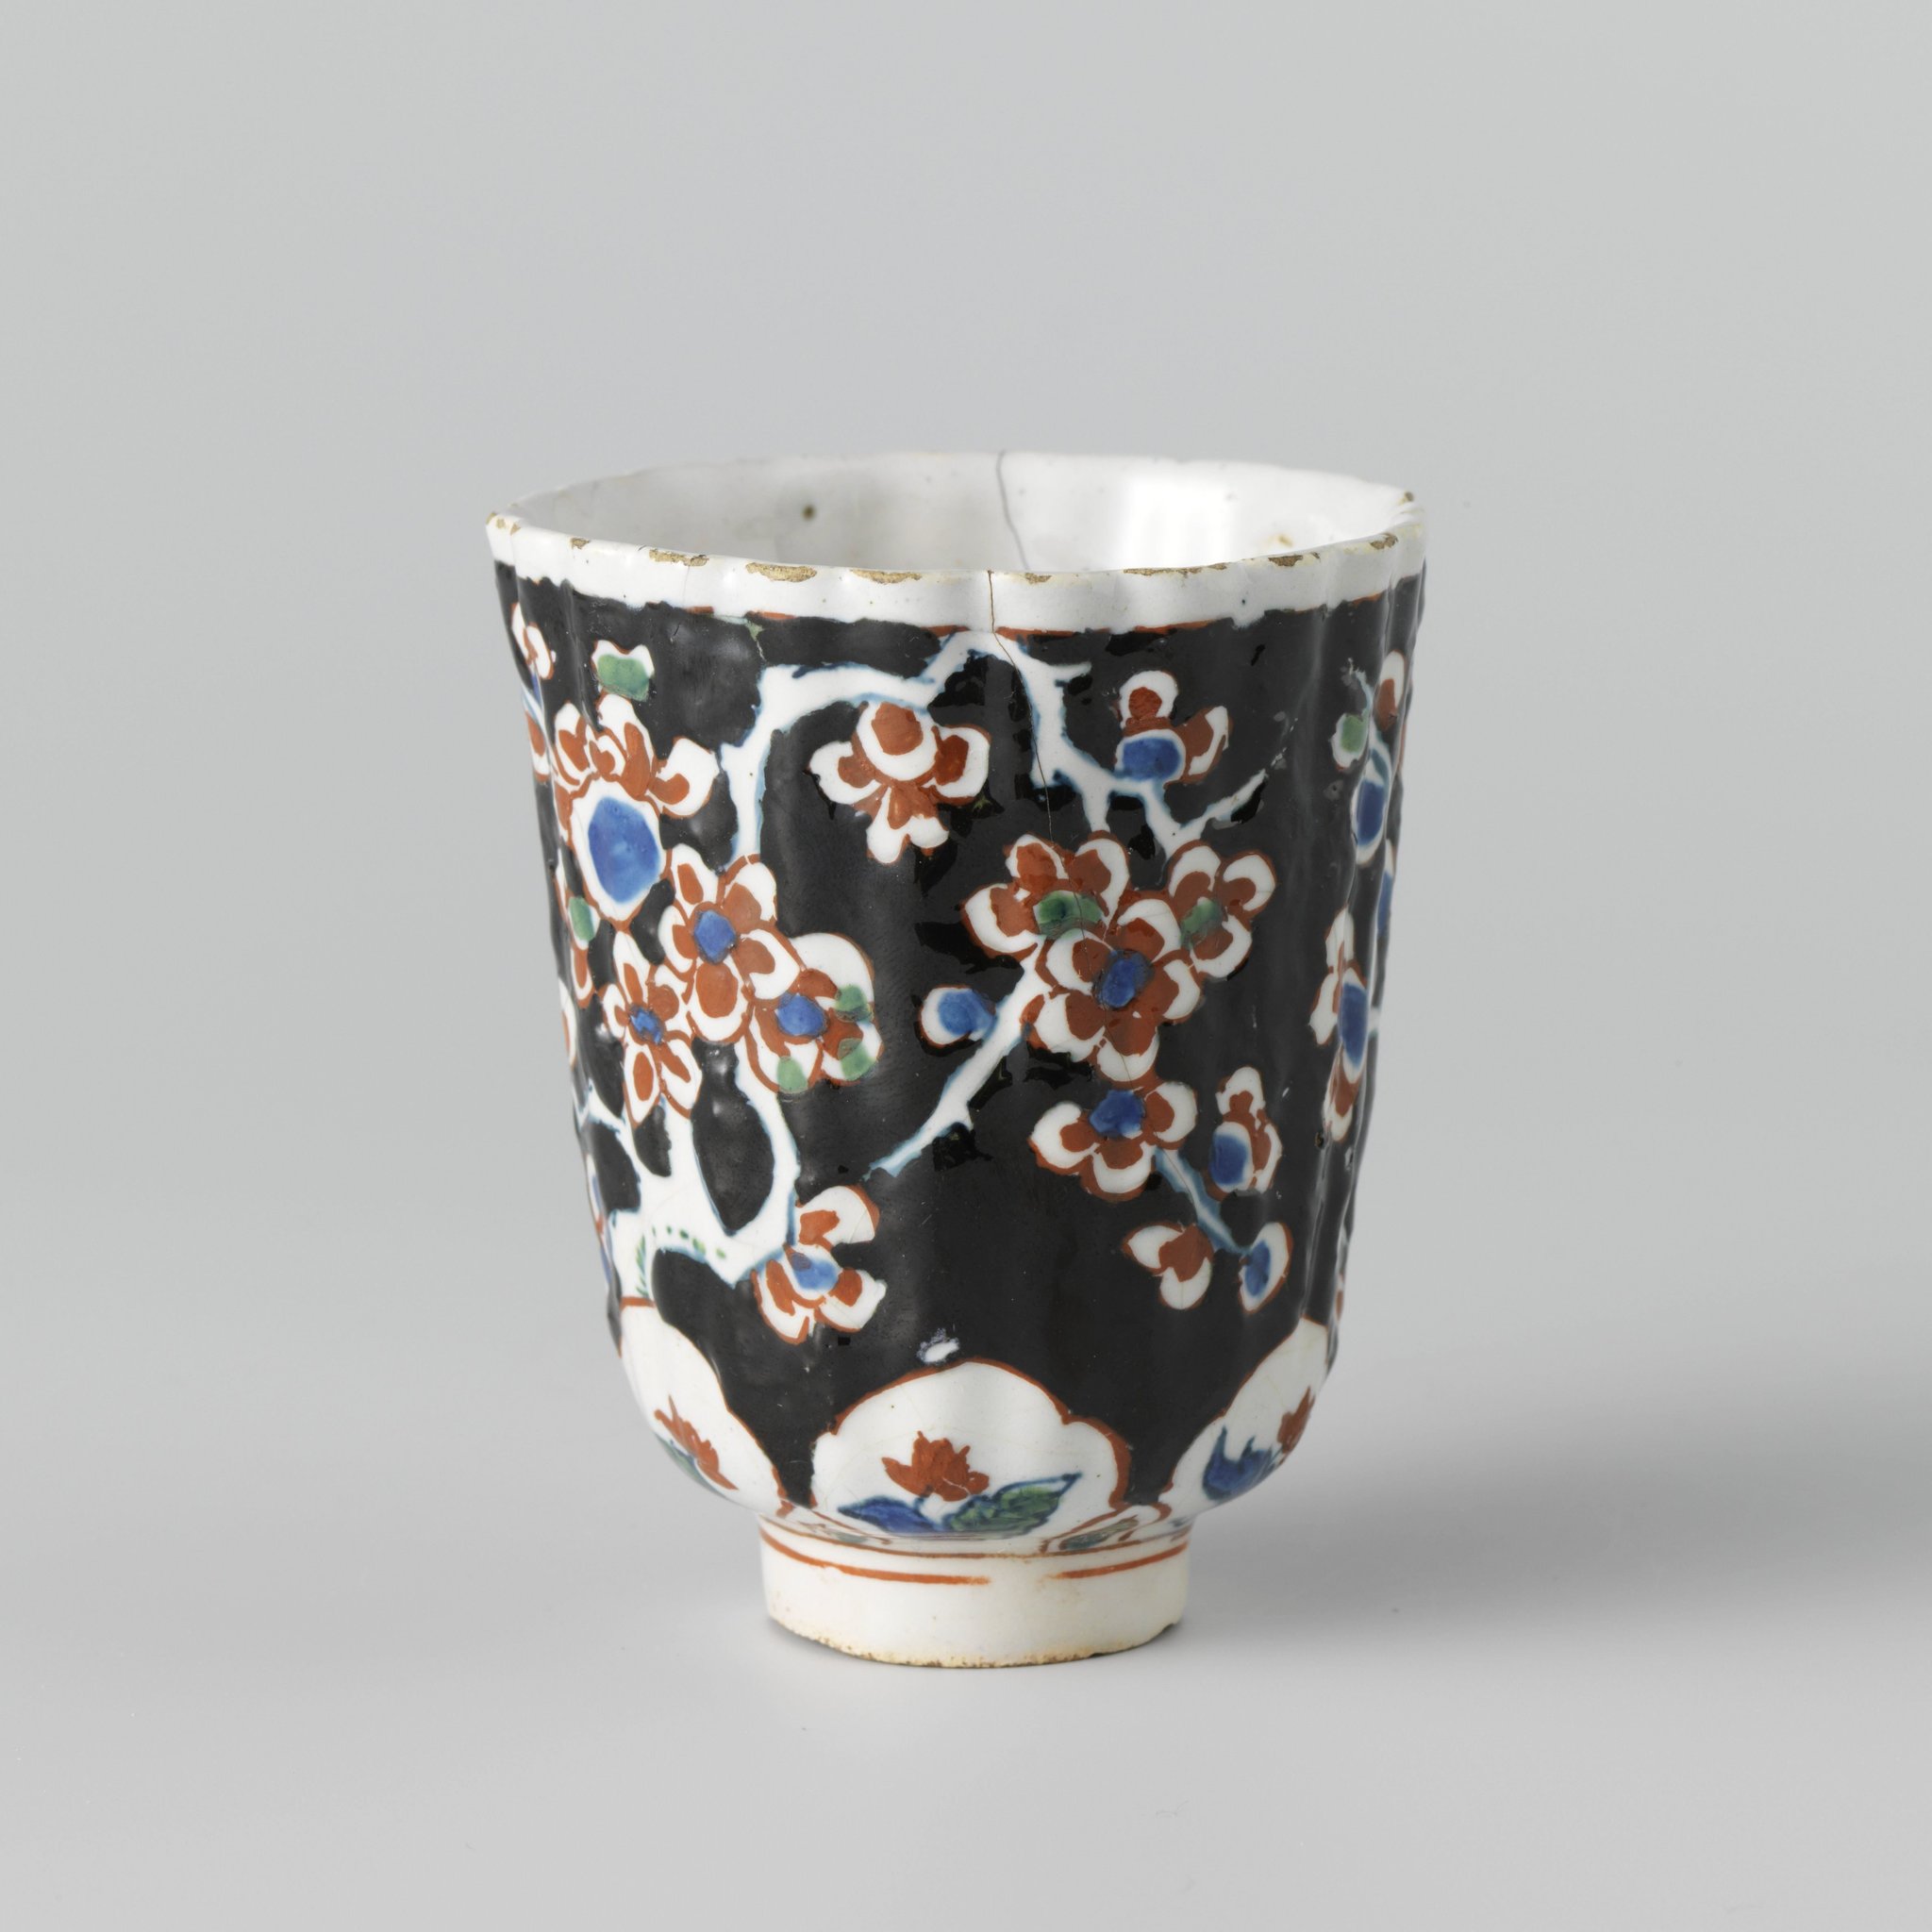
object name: trembleuse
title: Kop, behordend tot een trembleuse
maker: lambertus van eenhoorn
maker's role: plateelbakker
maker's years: 1651-1721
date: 1695-1720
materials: faience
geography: delft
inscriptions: collector's mark: ‘koninklijk oudheidkundig genootschap no. 22’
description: Kop van faience, behordend tot een trembleuse. Veelkleurig beschilderd met bloemtakken.